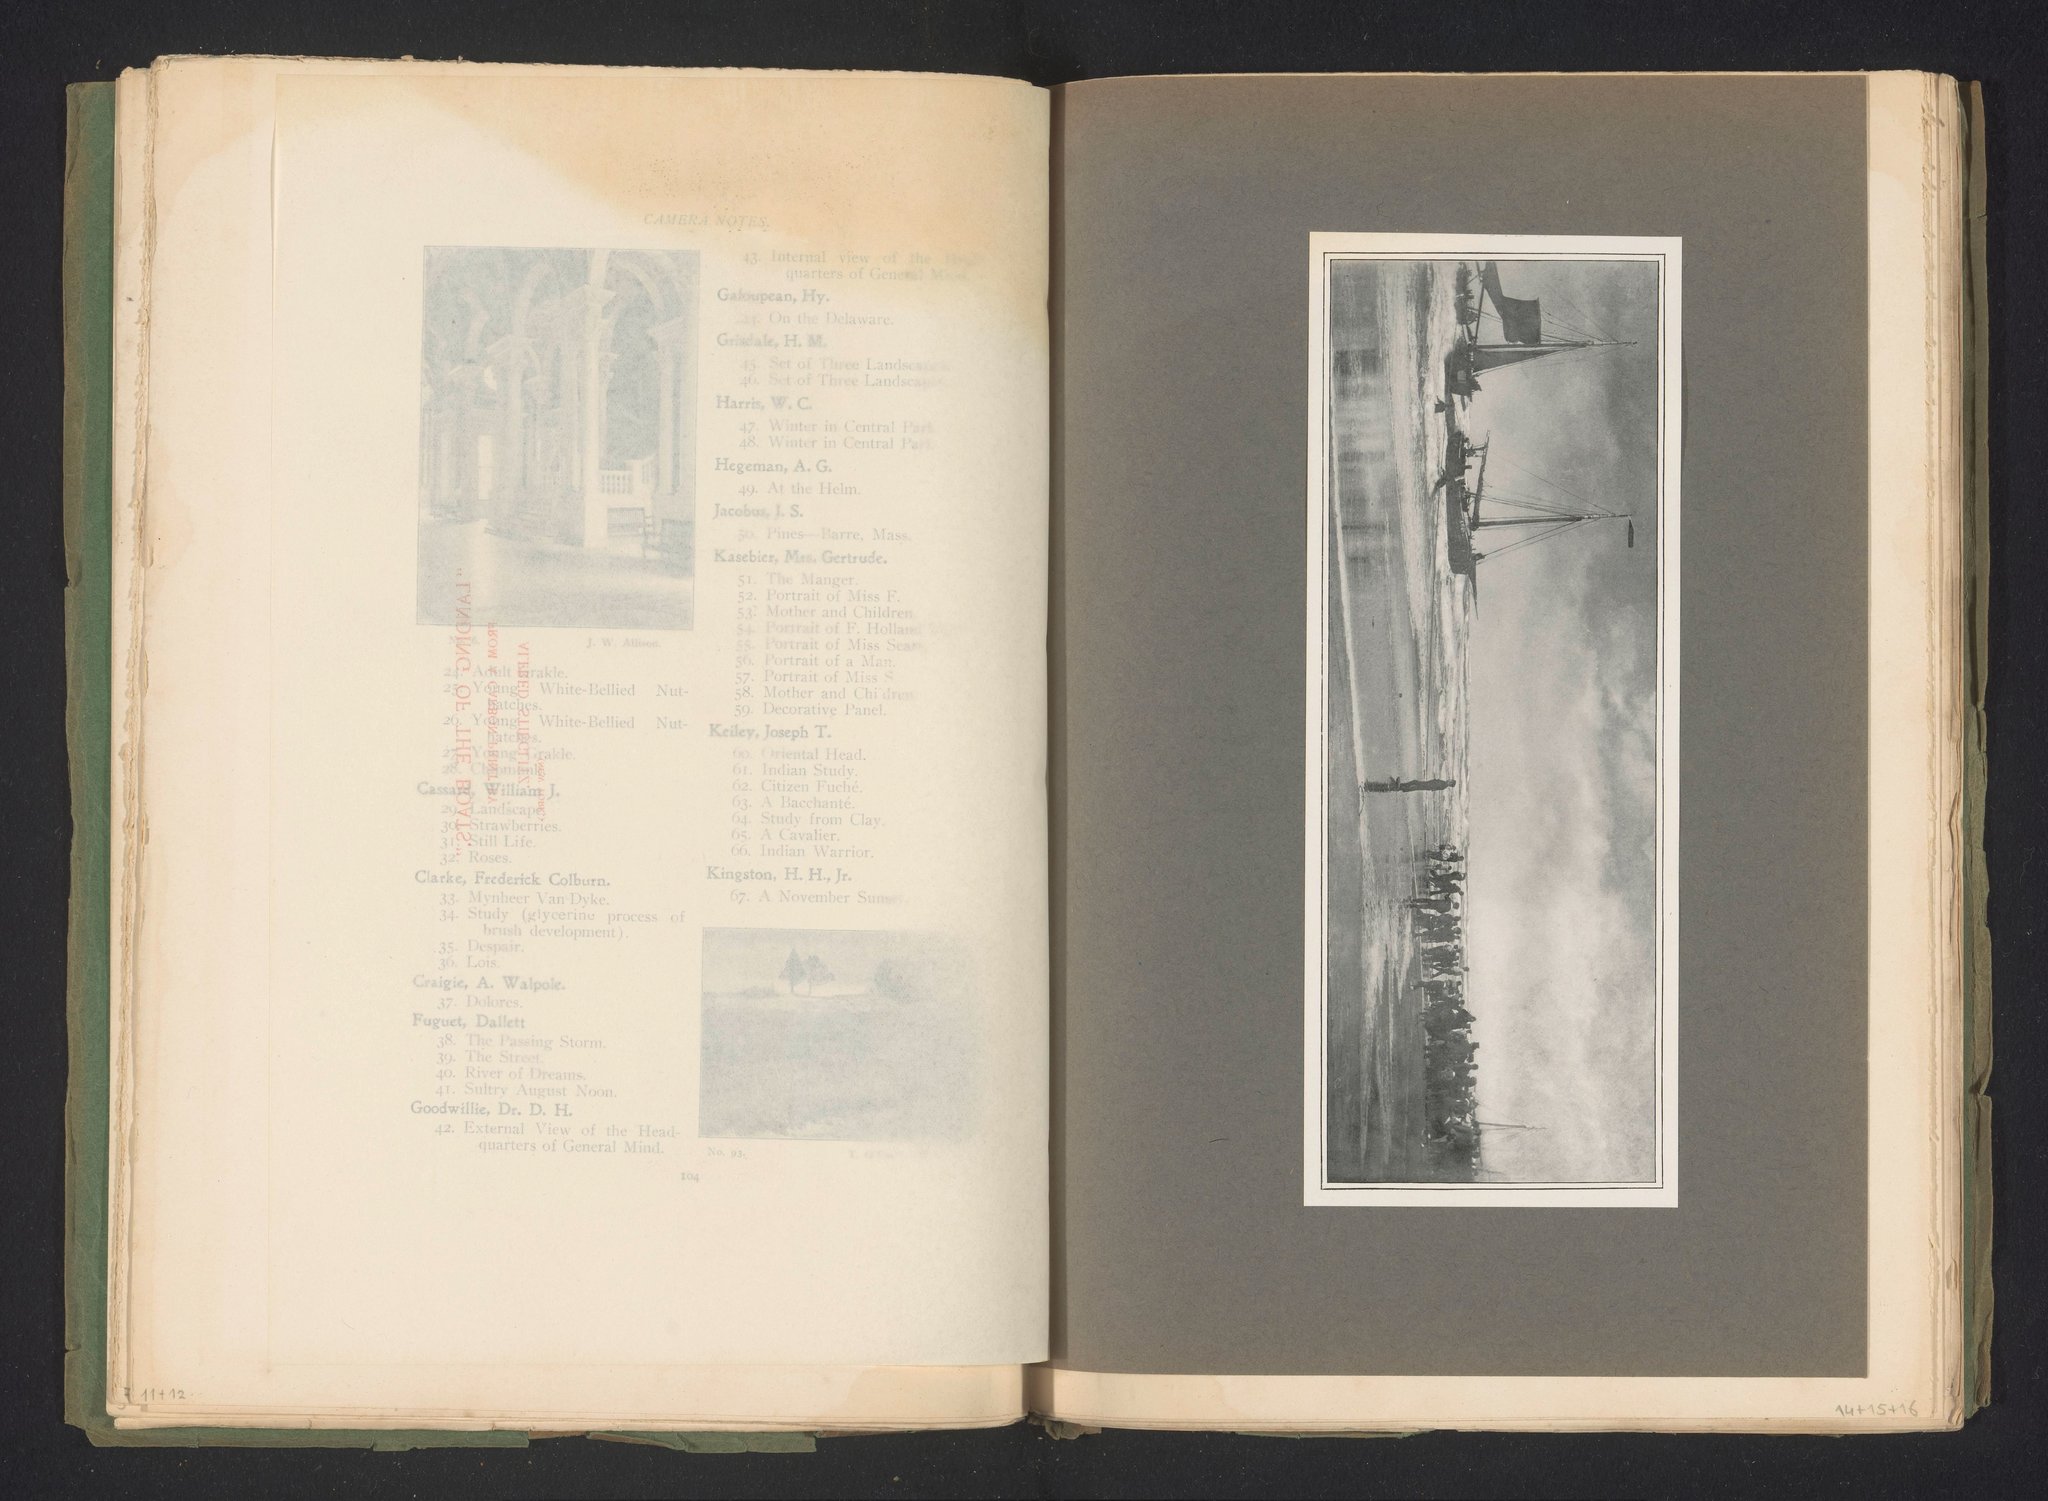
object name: photomechanical print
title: Drietal boten worden opgewacht door een groep mensen op het strand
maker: alfred stieglitz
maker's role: fotograaf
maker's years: 1864-1946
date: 1895-1900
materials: paper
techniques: autotype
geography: new york city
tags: sailing-ship, sailing-boat, beach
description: Prent tegenover pagina 104, achter semi-transparante omslag.